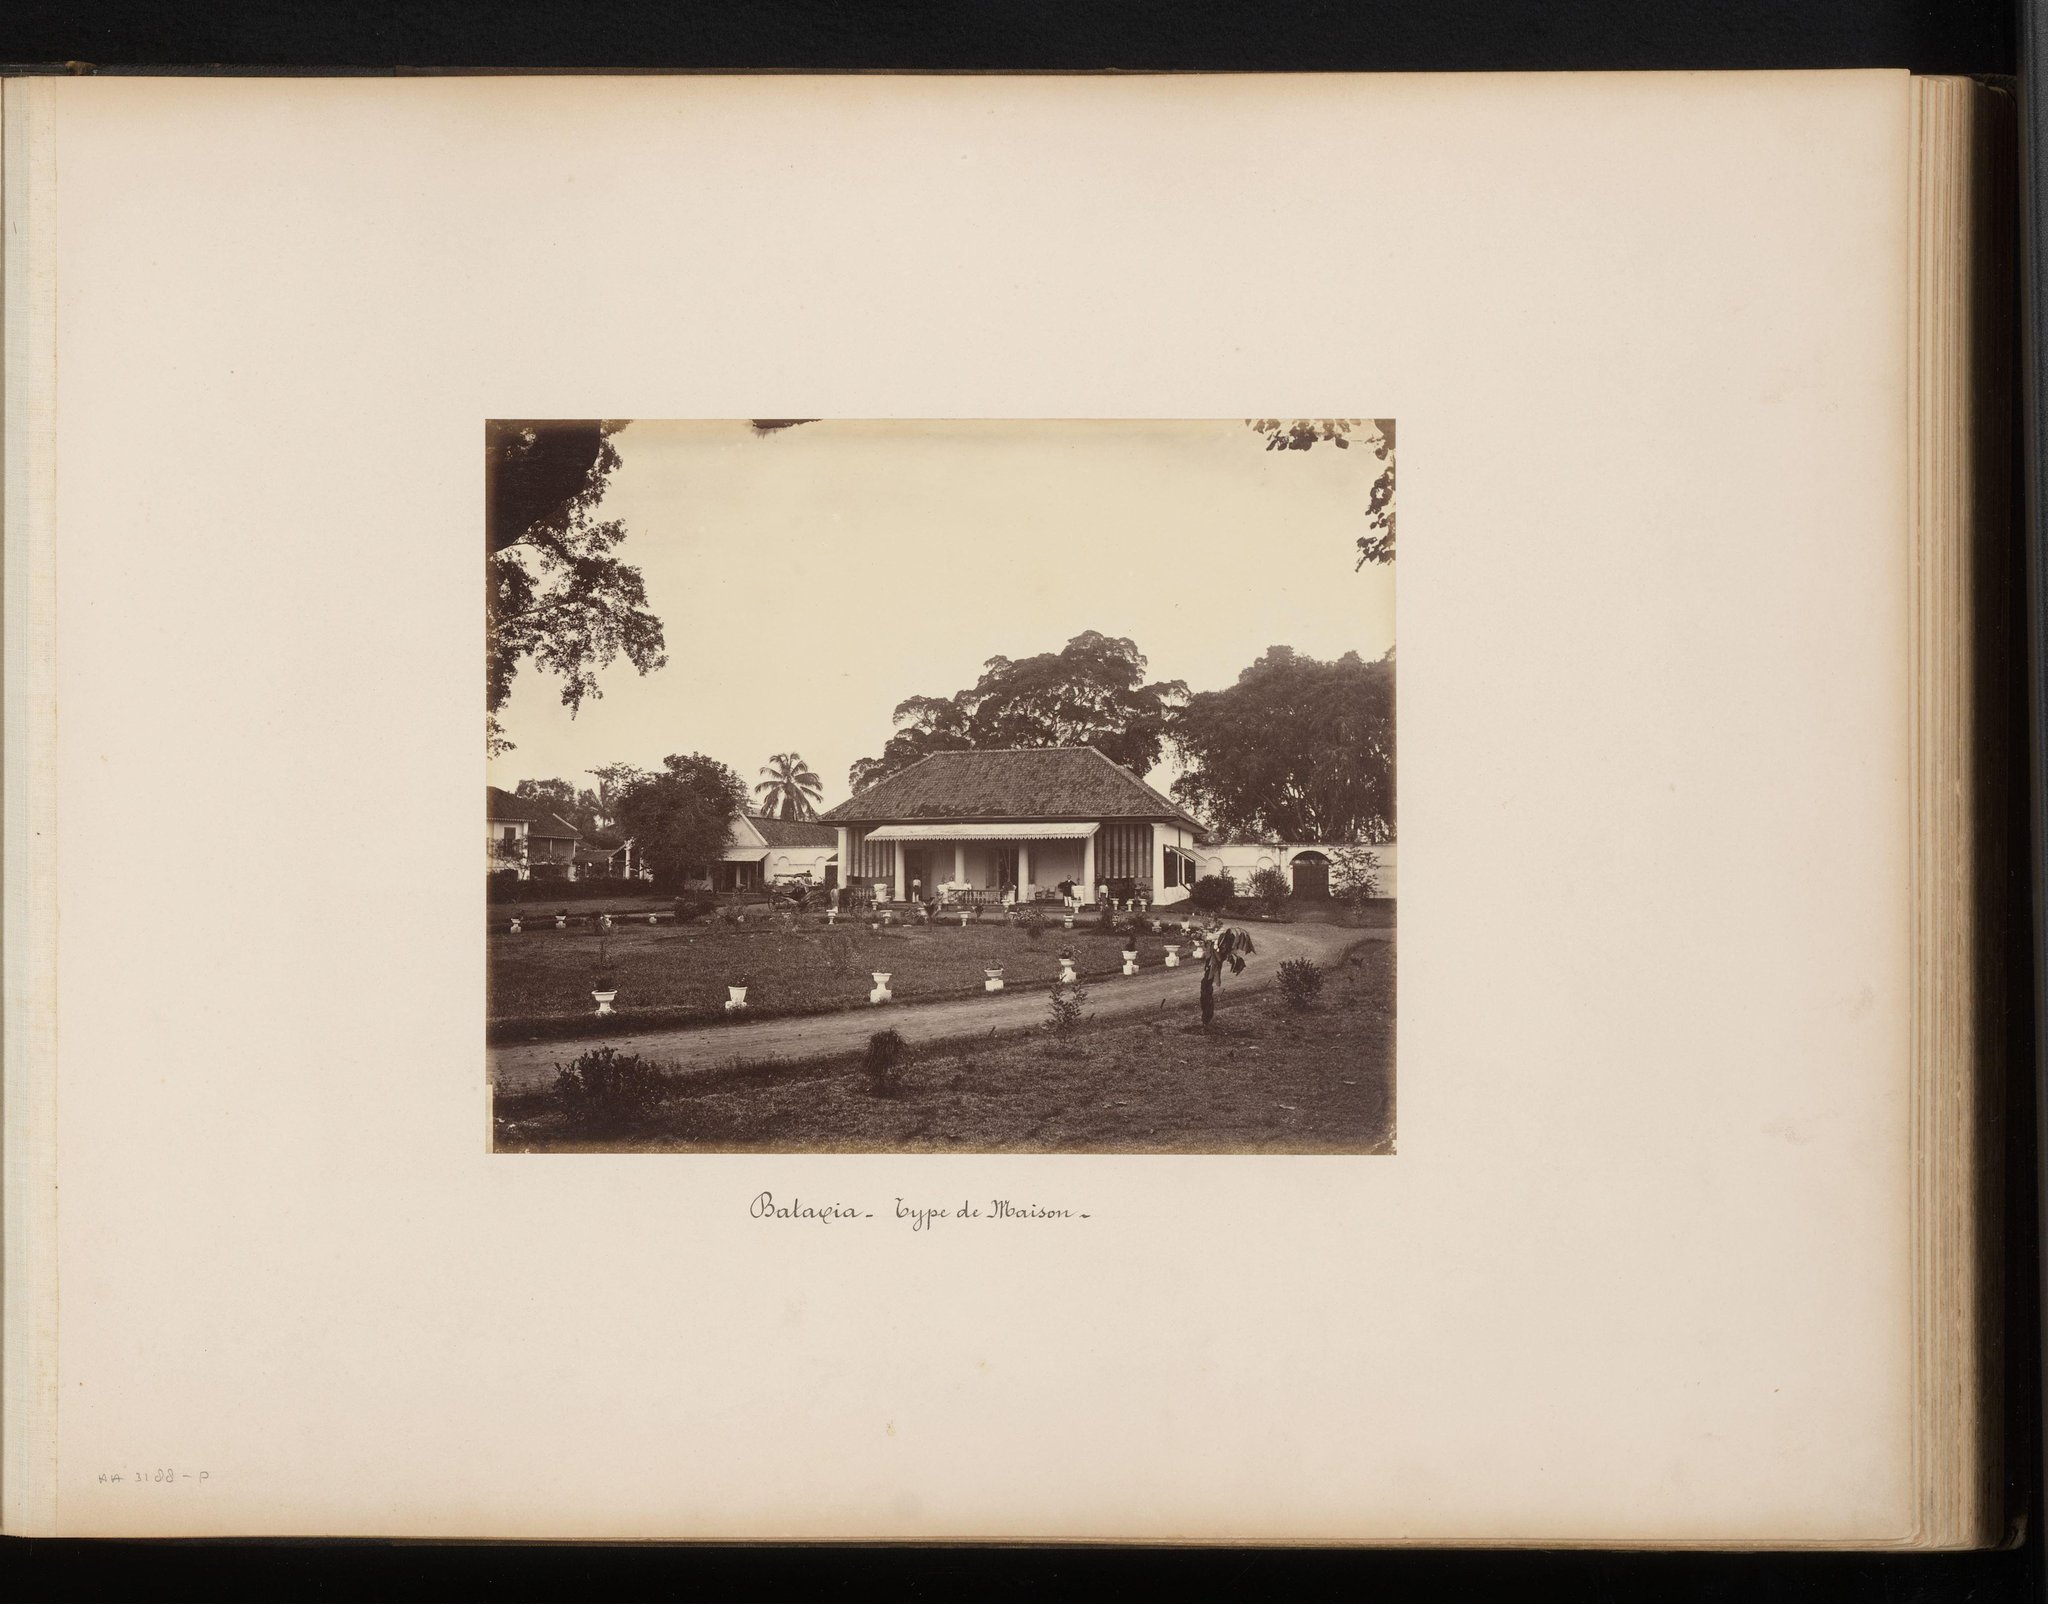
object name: photograph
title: Gezin met personeel voor een woning in Batavia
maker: Anonymous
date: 1880-1883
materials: photographic support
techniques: albumen print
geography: batavia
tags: rural housing, e.g. country-house, villa, cottage, batavia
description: Onderdeel van Reisalbum met opnames van bezienswaardigheden in Egypte, Nederlands-Indië, Singapore en Ceylon.